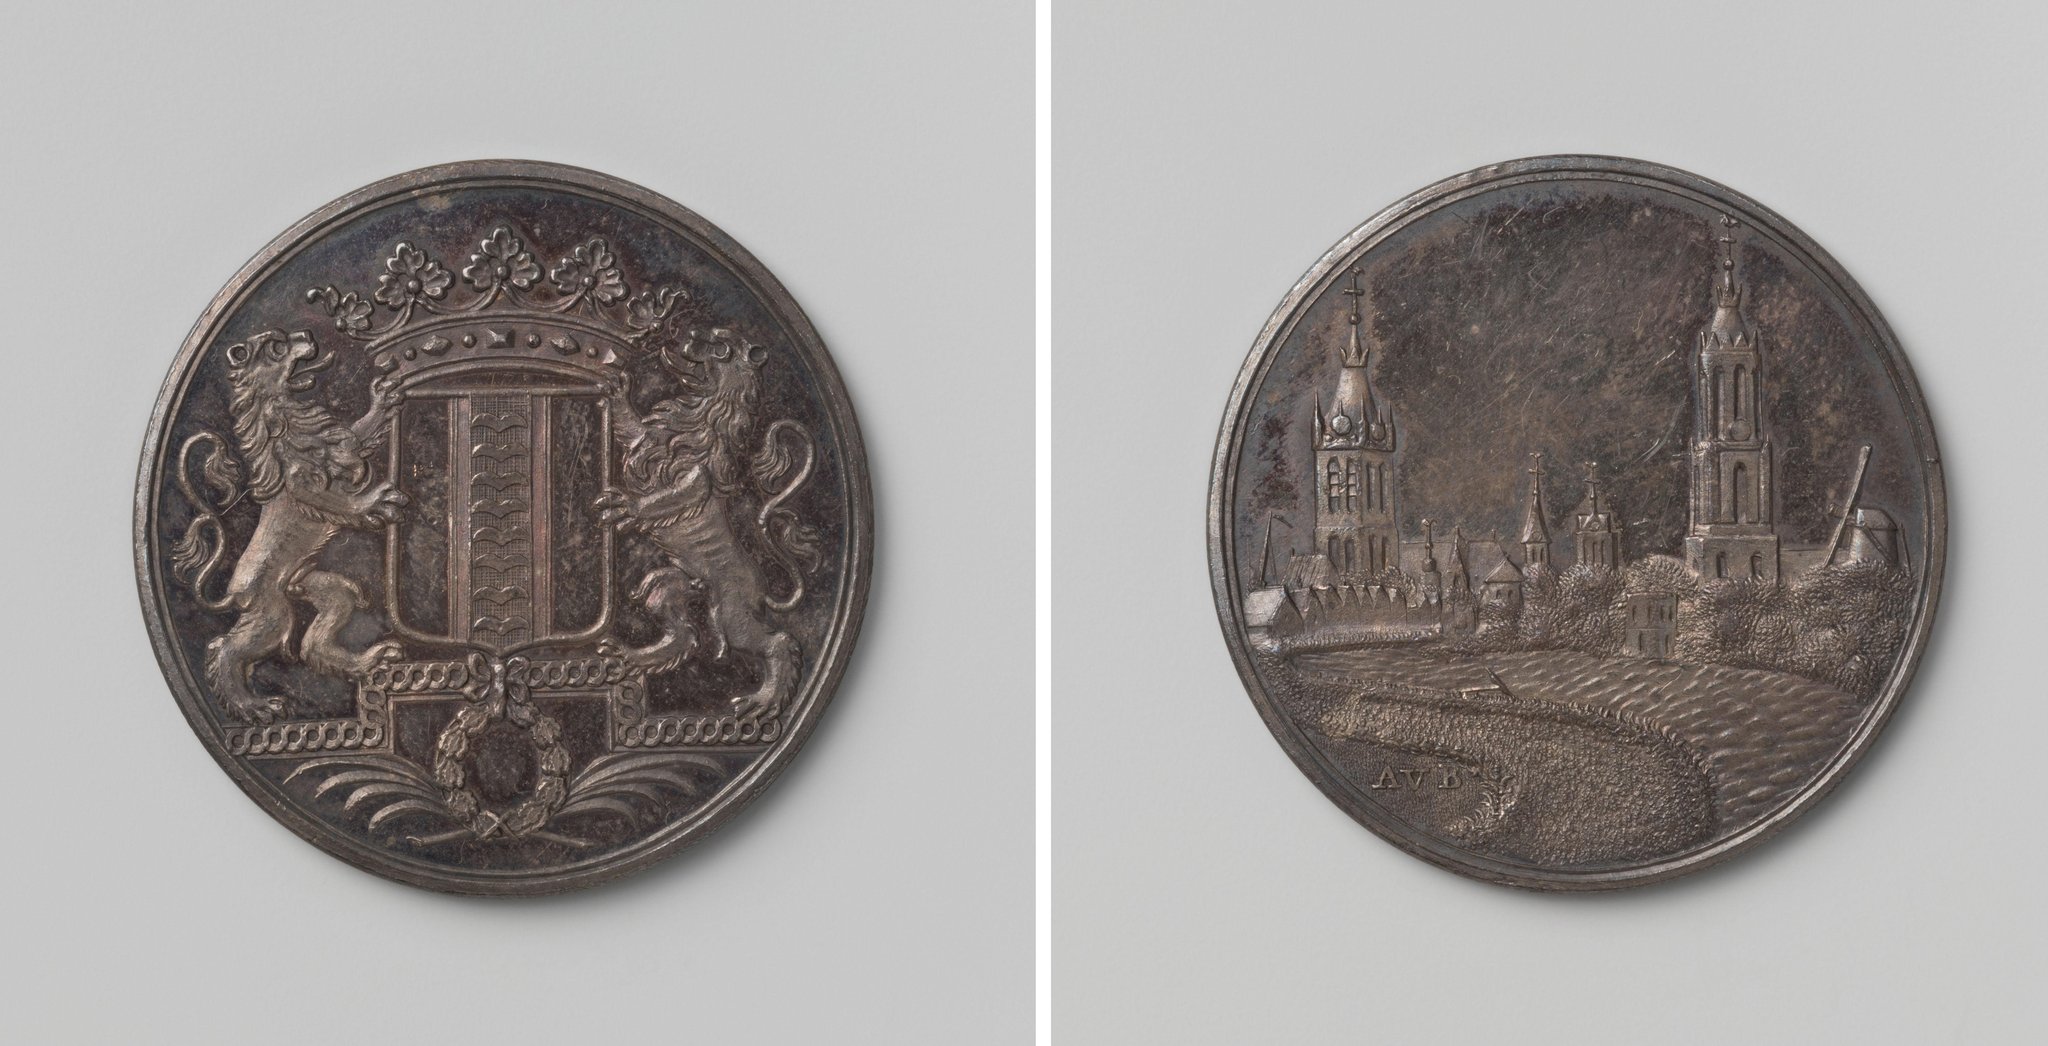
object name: council medal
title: Vroedschapspenning van de stad Delft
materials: silver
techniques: striking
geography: dordrecht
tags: delft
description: Zilveren penning. Voorzijde: gekroond wapenschild, geflankeerd door twee leeuwen, rustend op versierde dwarsbalk, waaraan eikekrans hangt, waarin twee gekruiste palmtakken gevlochten zijn. Keerzijde: gezicht op Delft; op voorgrond: jaagpad langs de Schie